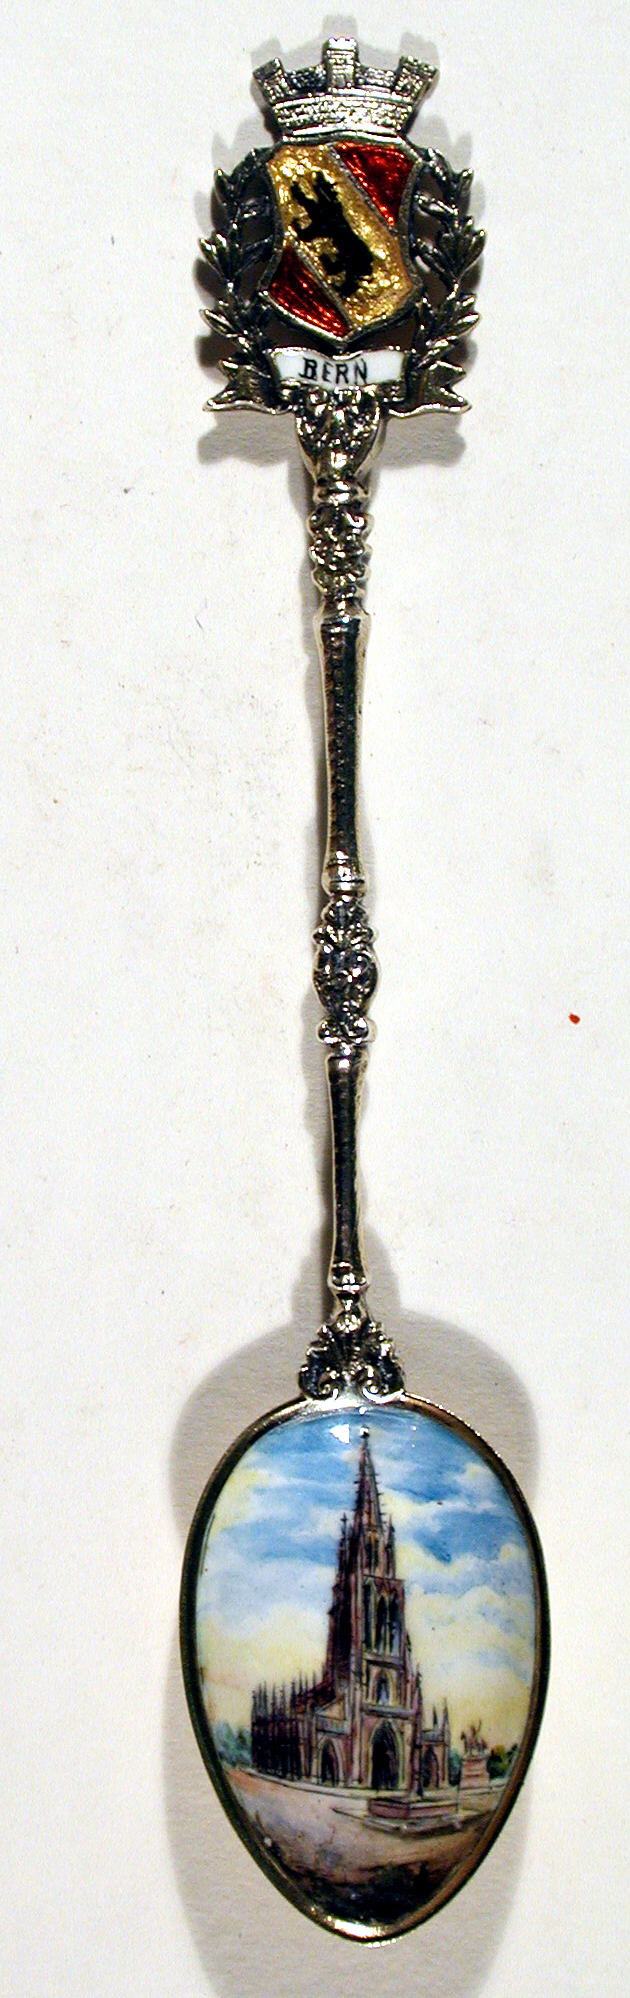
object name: souvenir spoon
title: Souvenir spoon with view of west front of a Gothic cathedral (Bern?)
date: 1867-1900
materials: enamel, gilt, silver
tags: churches,coat of arms